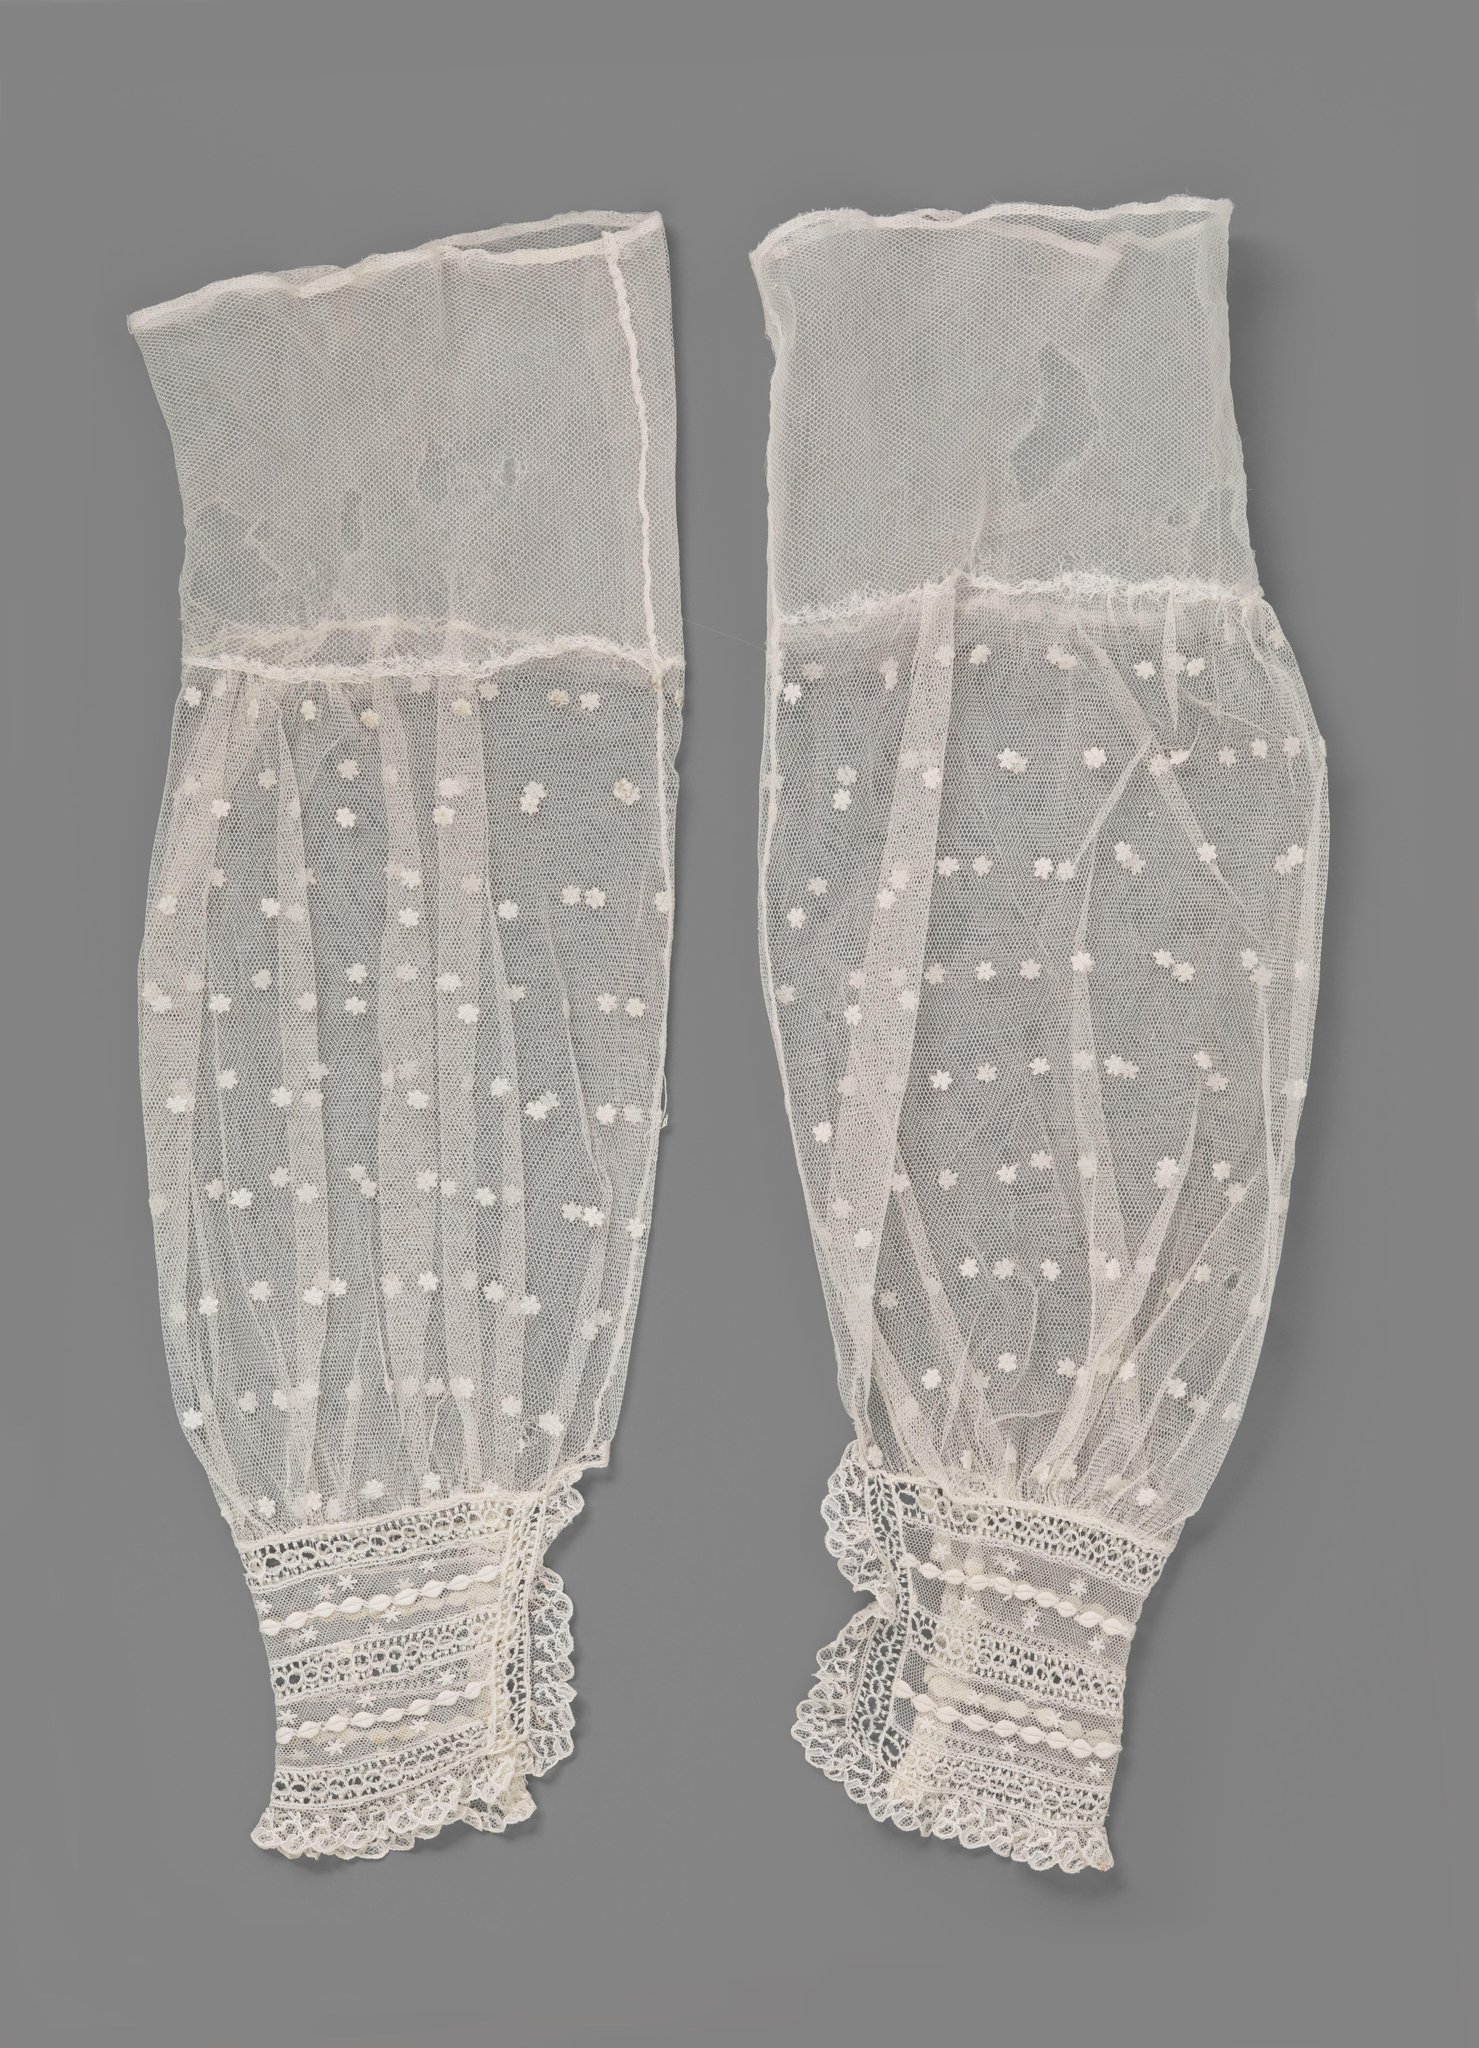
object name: womenswear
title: Voormouw met manchet van Rijsselse kant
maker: Anonymous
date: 1860-1880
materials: textile, mother of pearl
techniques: embroidered, lace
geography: western europe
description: Voormouw met manchet van Rijsselse kant. Het ballonmodel heeft een lange gladde manchet met tussenzetsels en een strook Rijsselse kant. De mouw is geborduurd met bloemen en de manchet met sterren en bladeren. De drie kanten tussenzetsels in de manchet bestaan elk uit een rij ronde gaten tussen strepen. De tule in de manchet is van een fijnere kwaliteit dan die van de mouw en is gedecoreerd met sterren en een aangenaaid lint in de vorm van koffiebonen. De boord van de manchet is geschulpt met een rij gebogen bloemtakken. De manchet heeft drie knopen